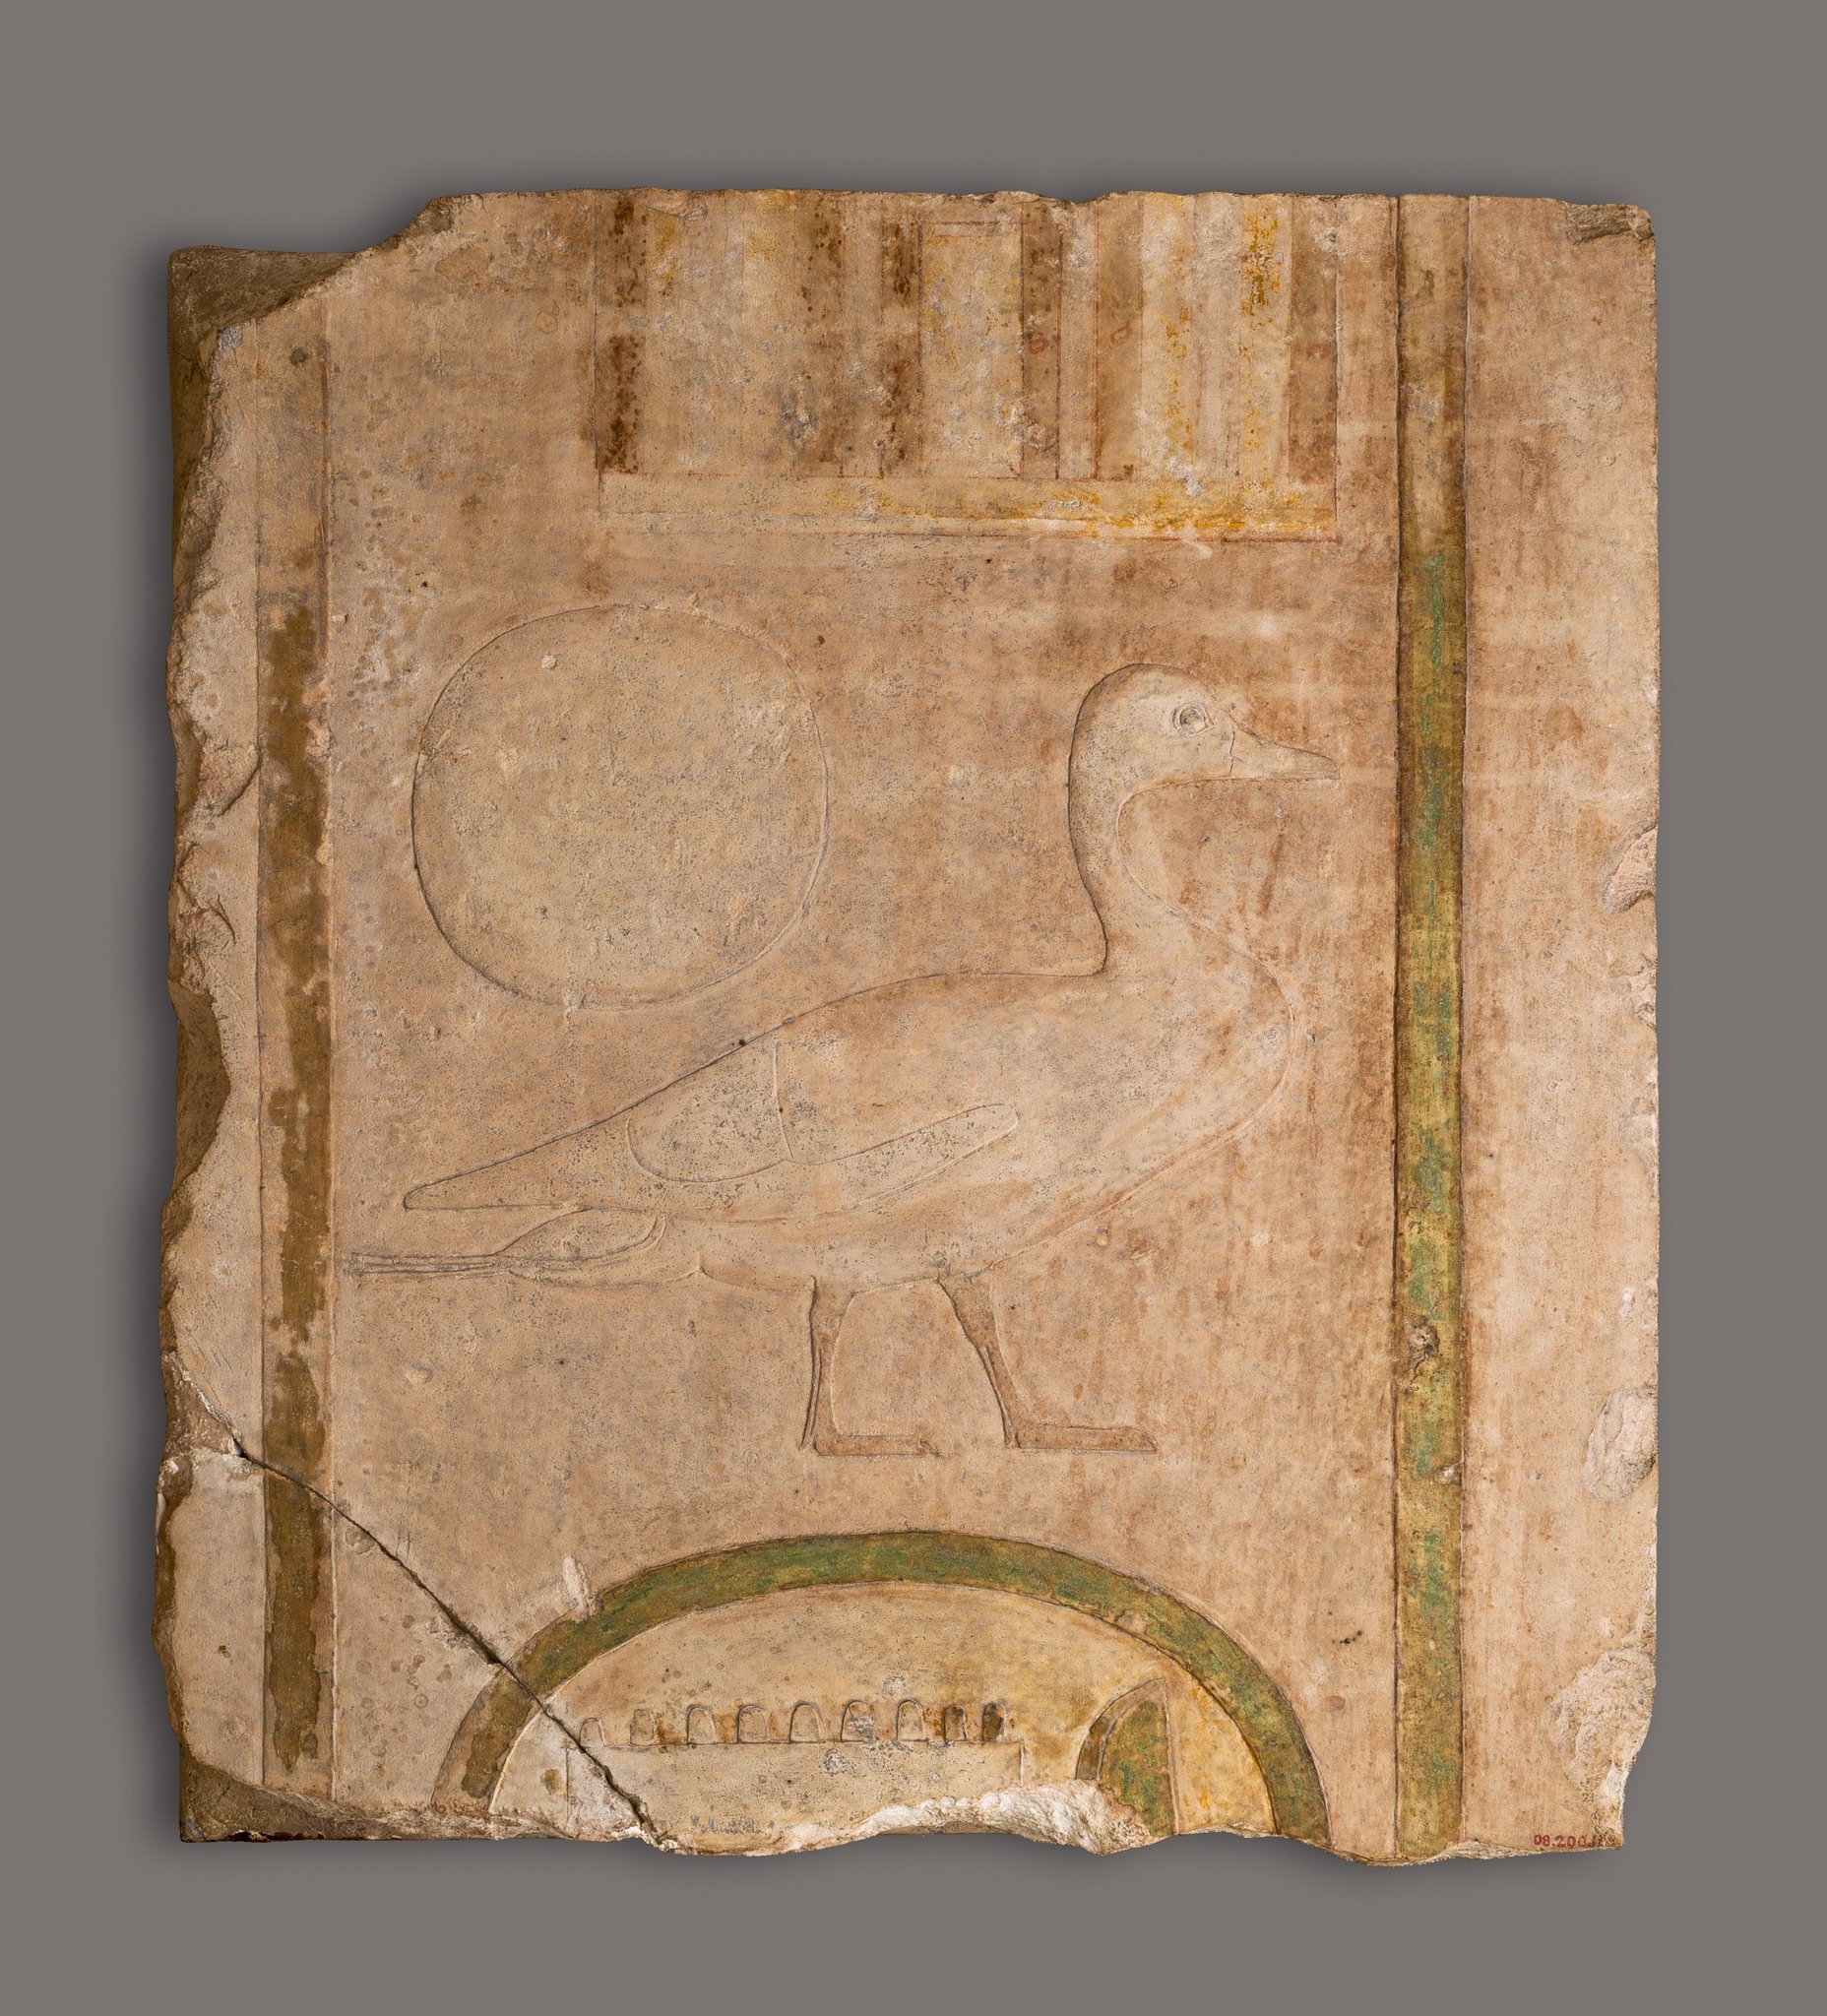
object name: relief, son of re, name of amenemhat i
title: Relief fragment with the Son of Re name of Amenemhat I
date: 1981-1952 BCE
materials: limestone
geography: egypt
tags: birds